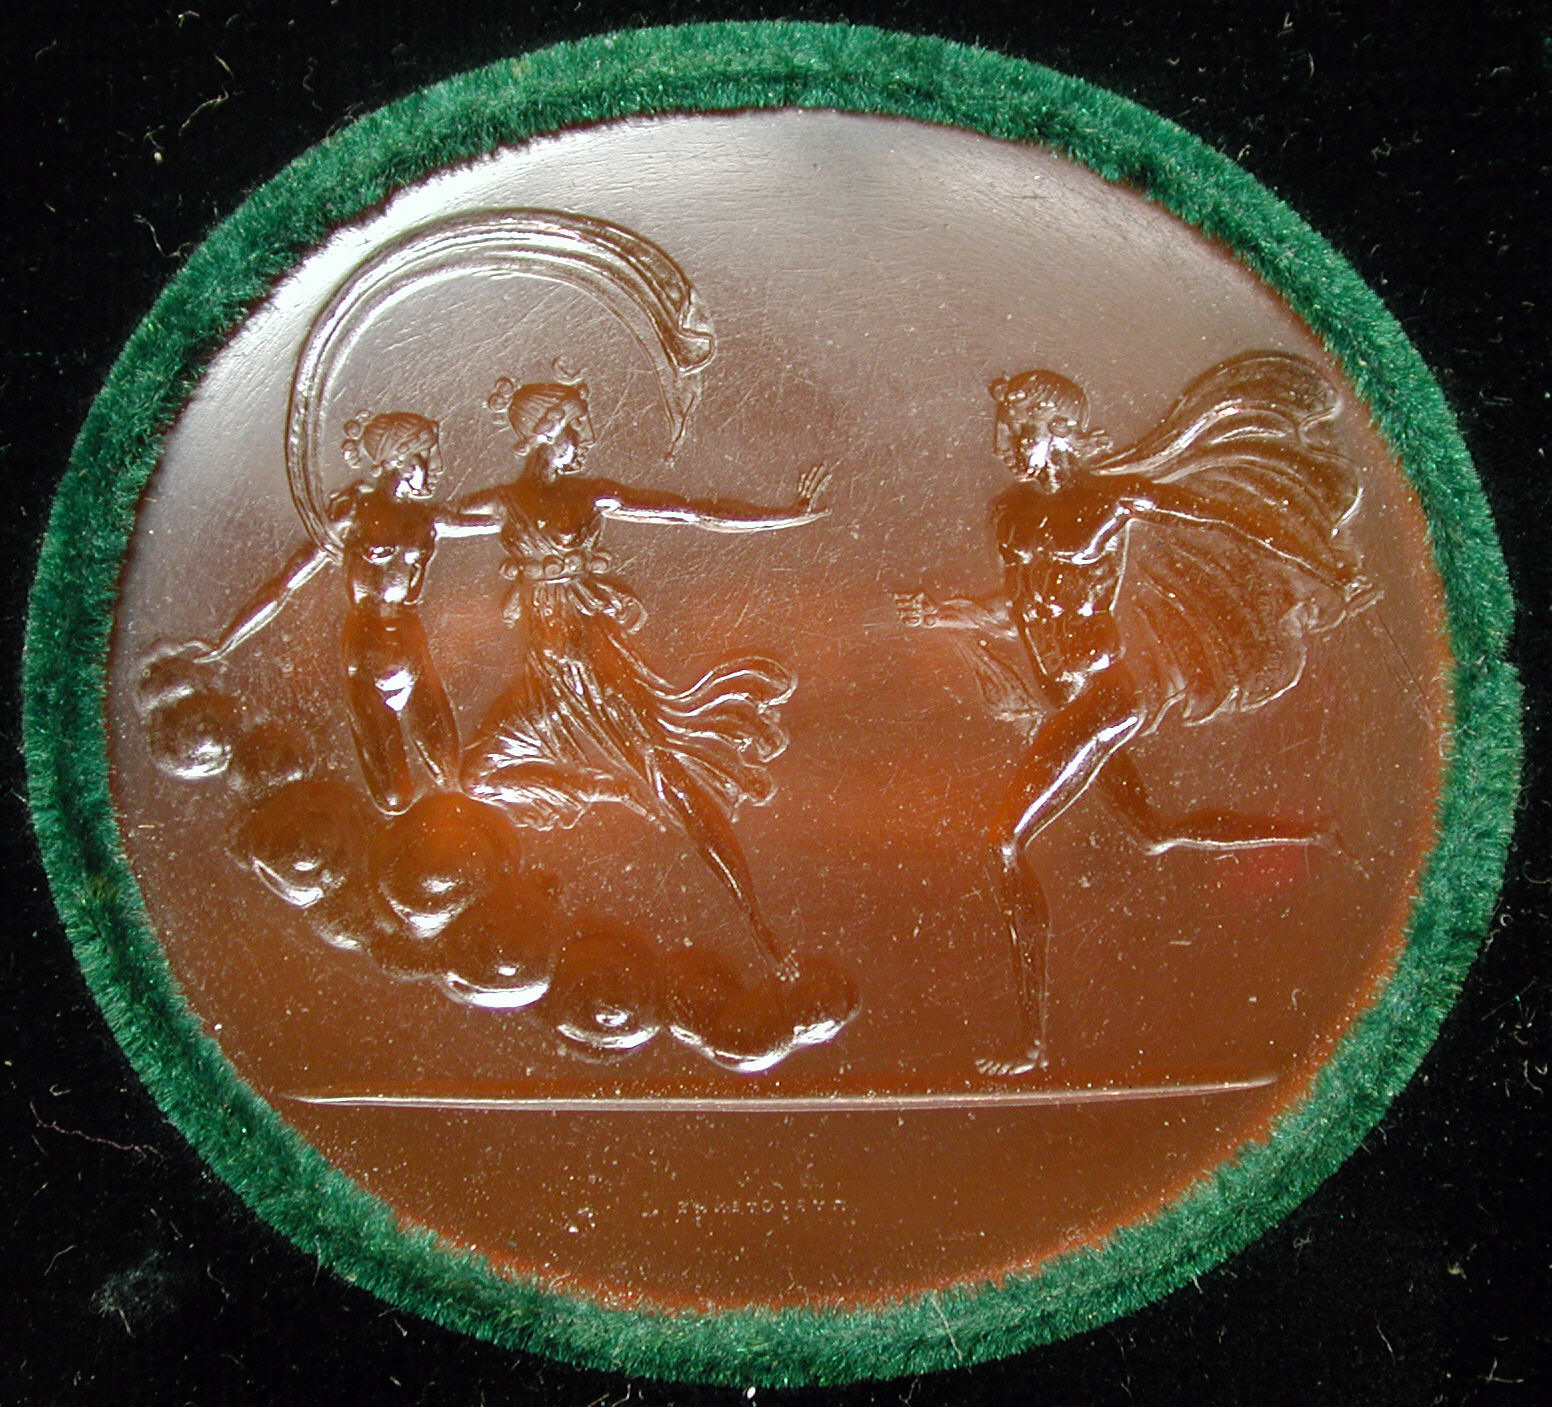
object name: intaglio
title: Diana protecting Erigone from the fury of Orestes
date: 1801-1833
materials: gemstone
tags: male nudes,female nudes,diana